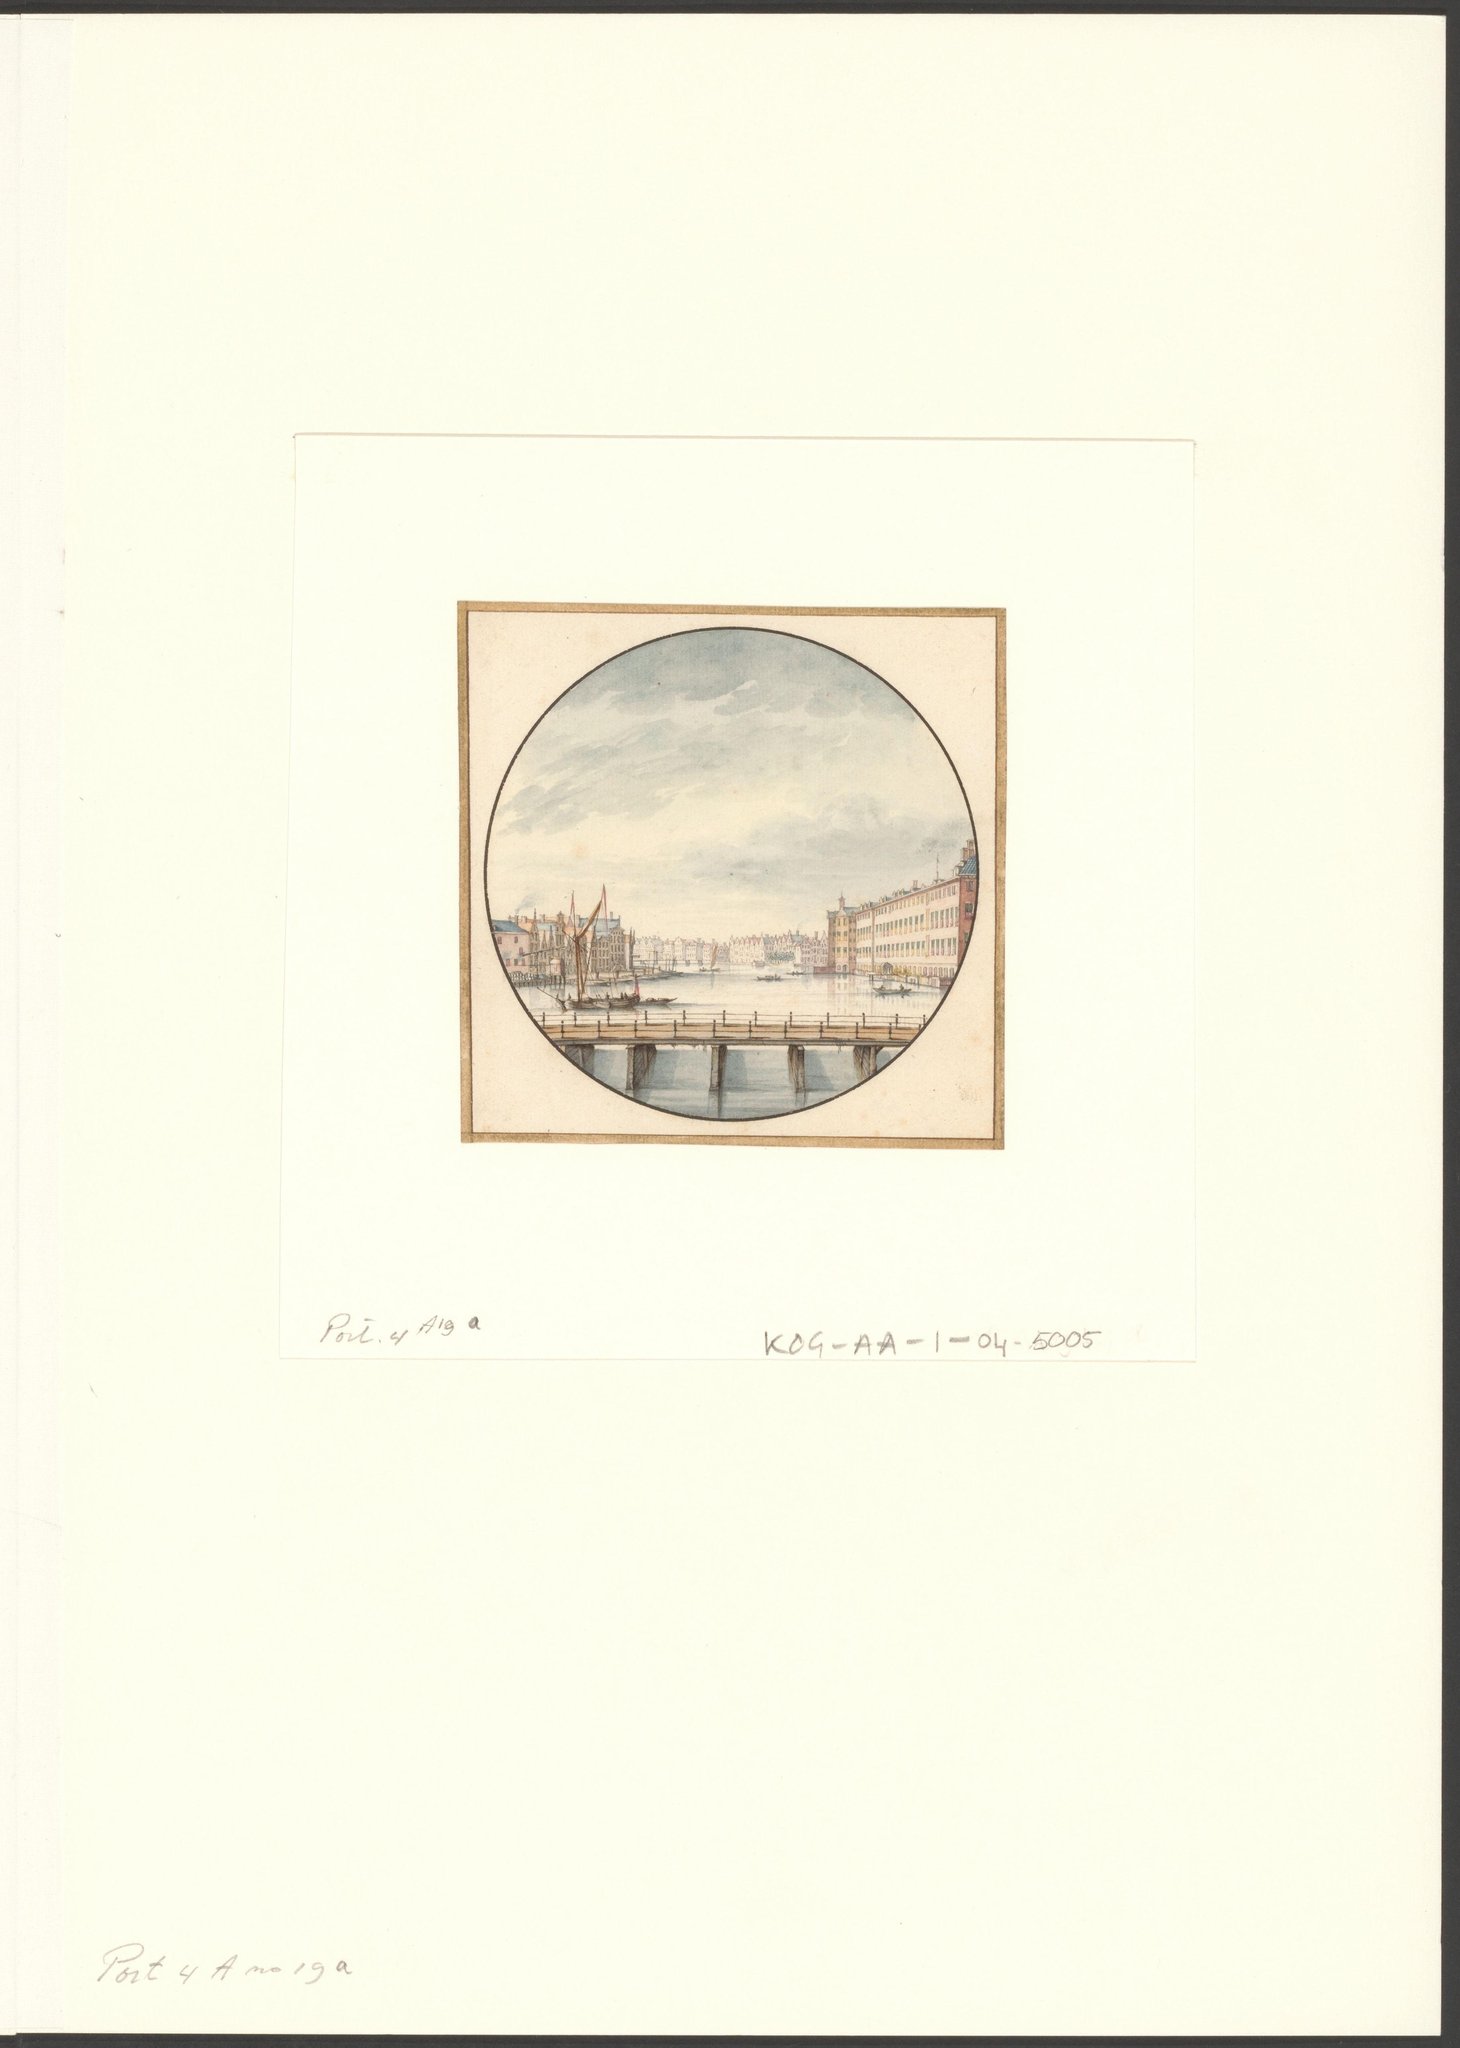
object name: drawing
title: Gezicht op de Amstel tussen de Blauwbrug en Halvemaansbrug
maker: jan van call (i)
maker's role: draughtsman, print maker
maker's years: 1656-1706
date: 1666-1703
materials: paint, ink, paper, pencil, watercolor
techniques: brush, pen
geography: amsterdam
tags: sailing-ship, sailing-boat, city-view in general; 'veduta', canal, bridge in city across river, canal, etc.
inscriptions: inscription: ‘Port. 4a191’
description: Onderwerpsrubriek binnen de Atlas Amsterdam: Amstel van Doelensluis tot Blauwbrug.